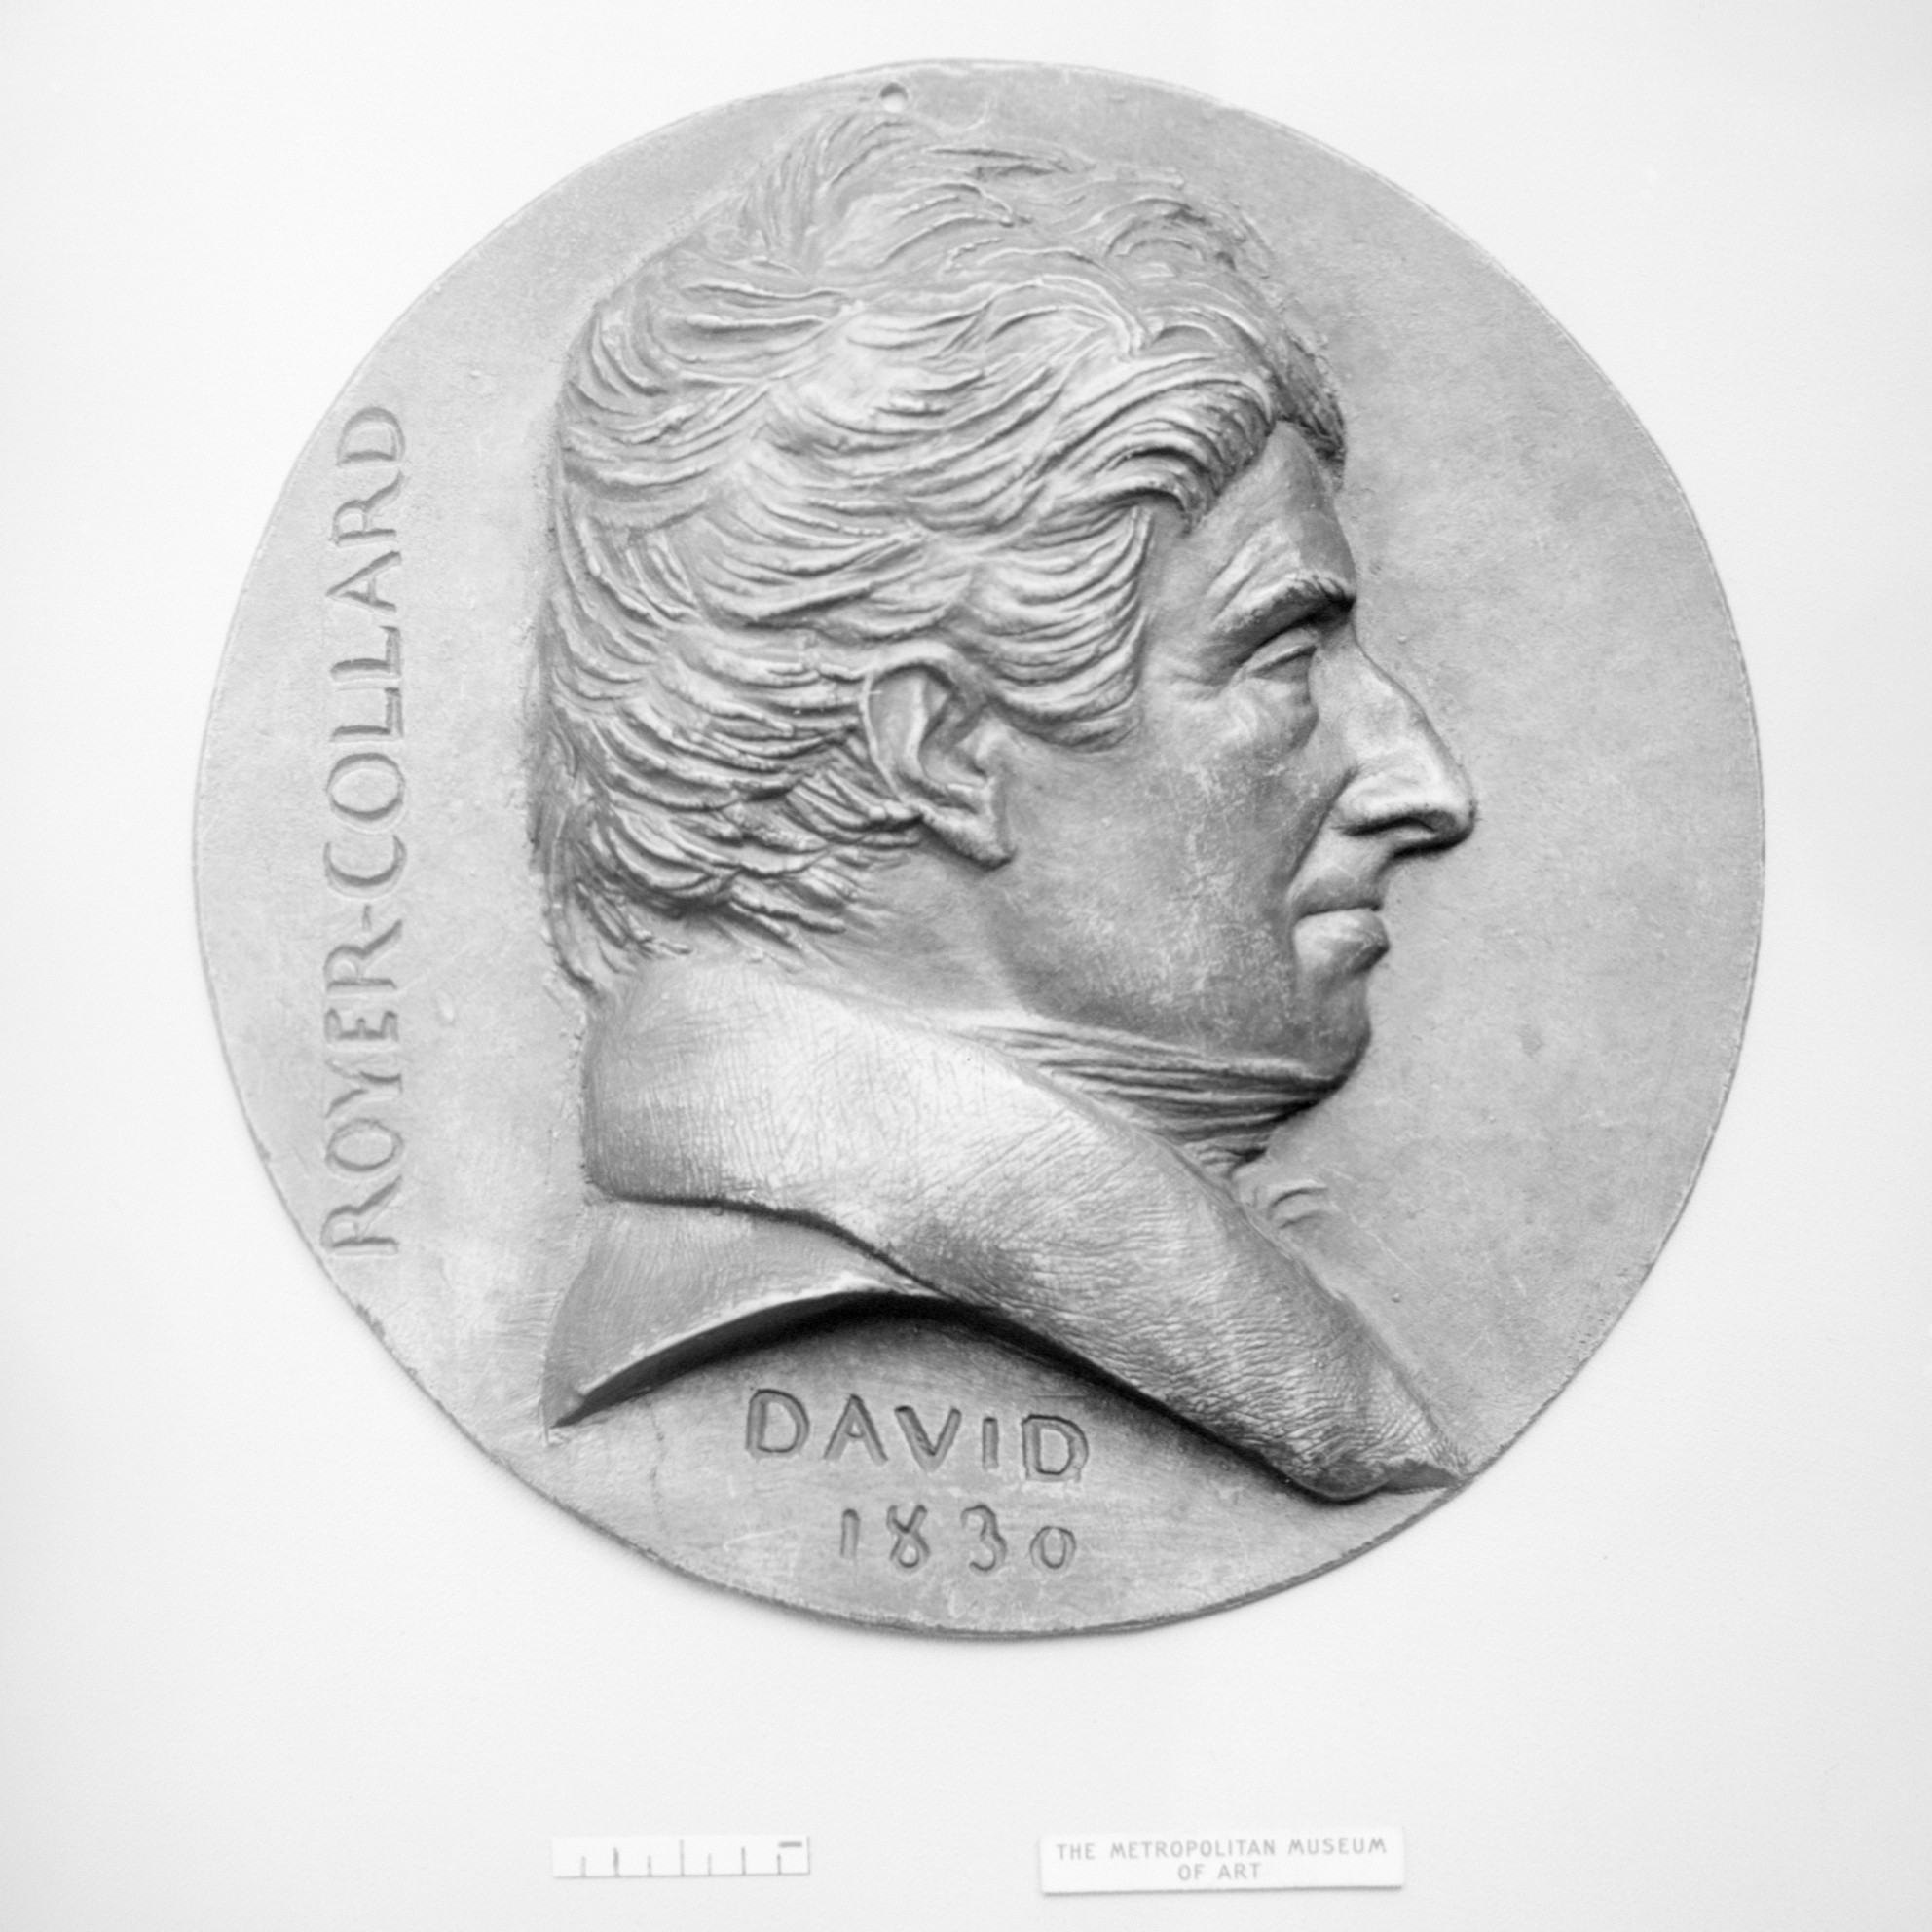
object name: medallion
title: Pierre Paul Royer-Collard (1763–1845), French editor, philosopher, statesman, and Member of the Academy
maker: pierre jean david d'angers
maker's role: artist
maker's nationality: french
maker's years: 1788-1856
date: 1830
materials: bronze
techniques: casting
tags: men,profiles